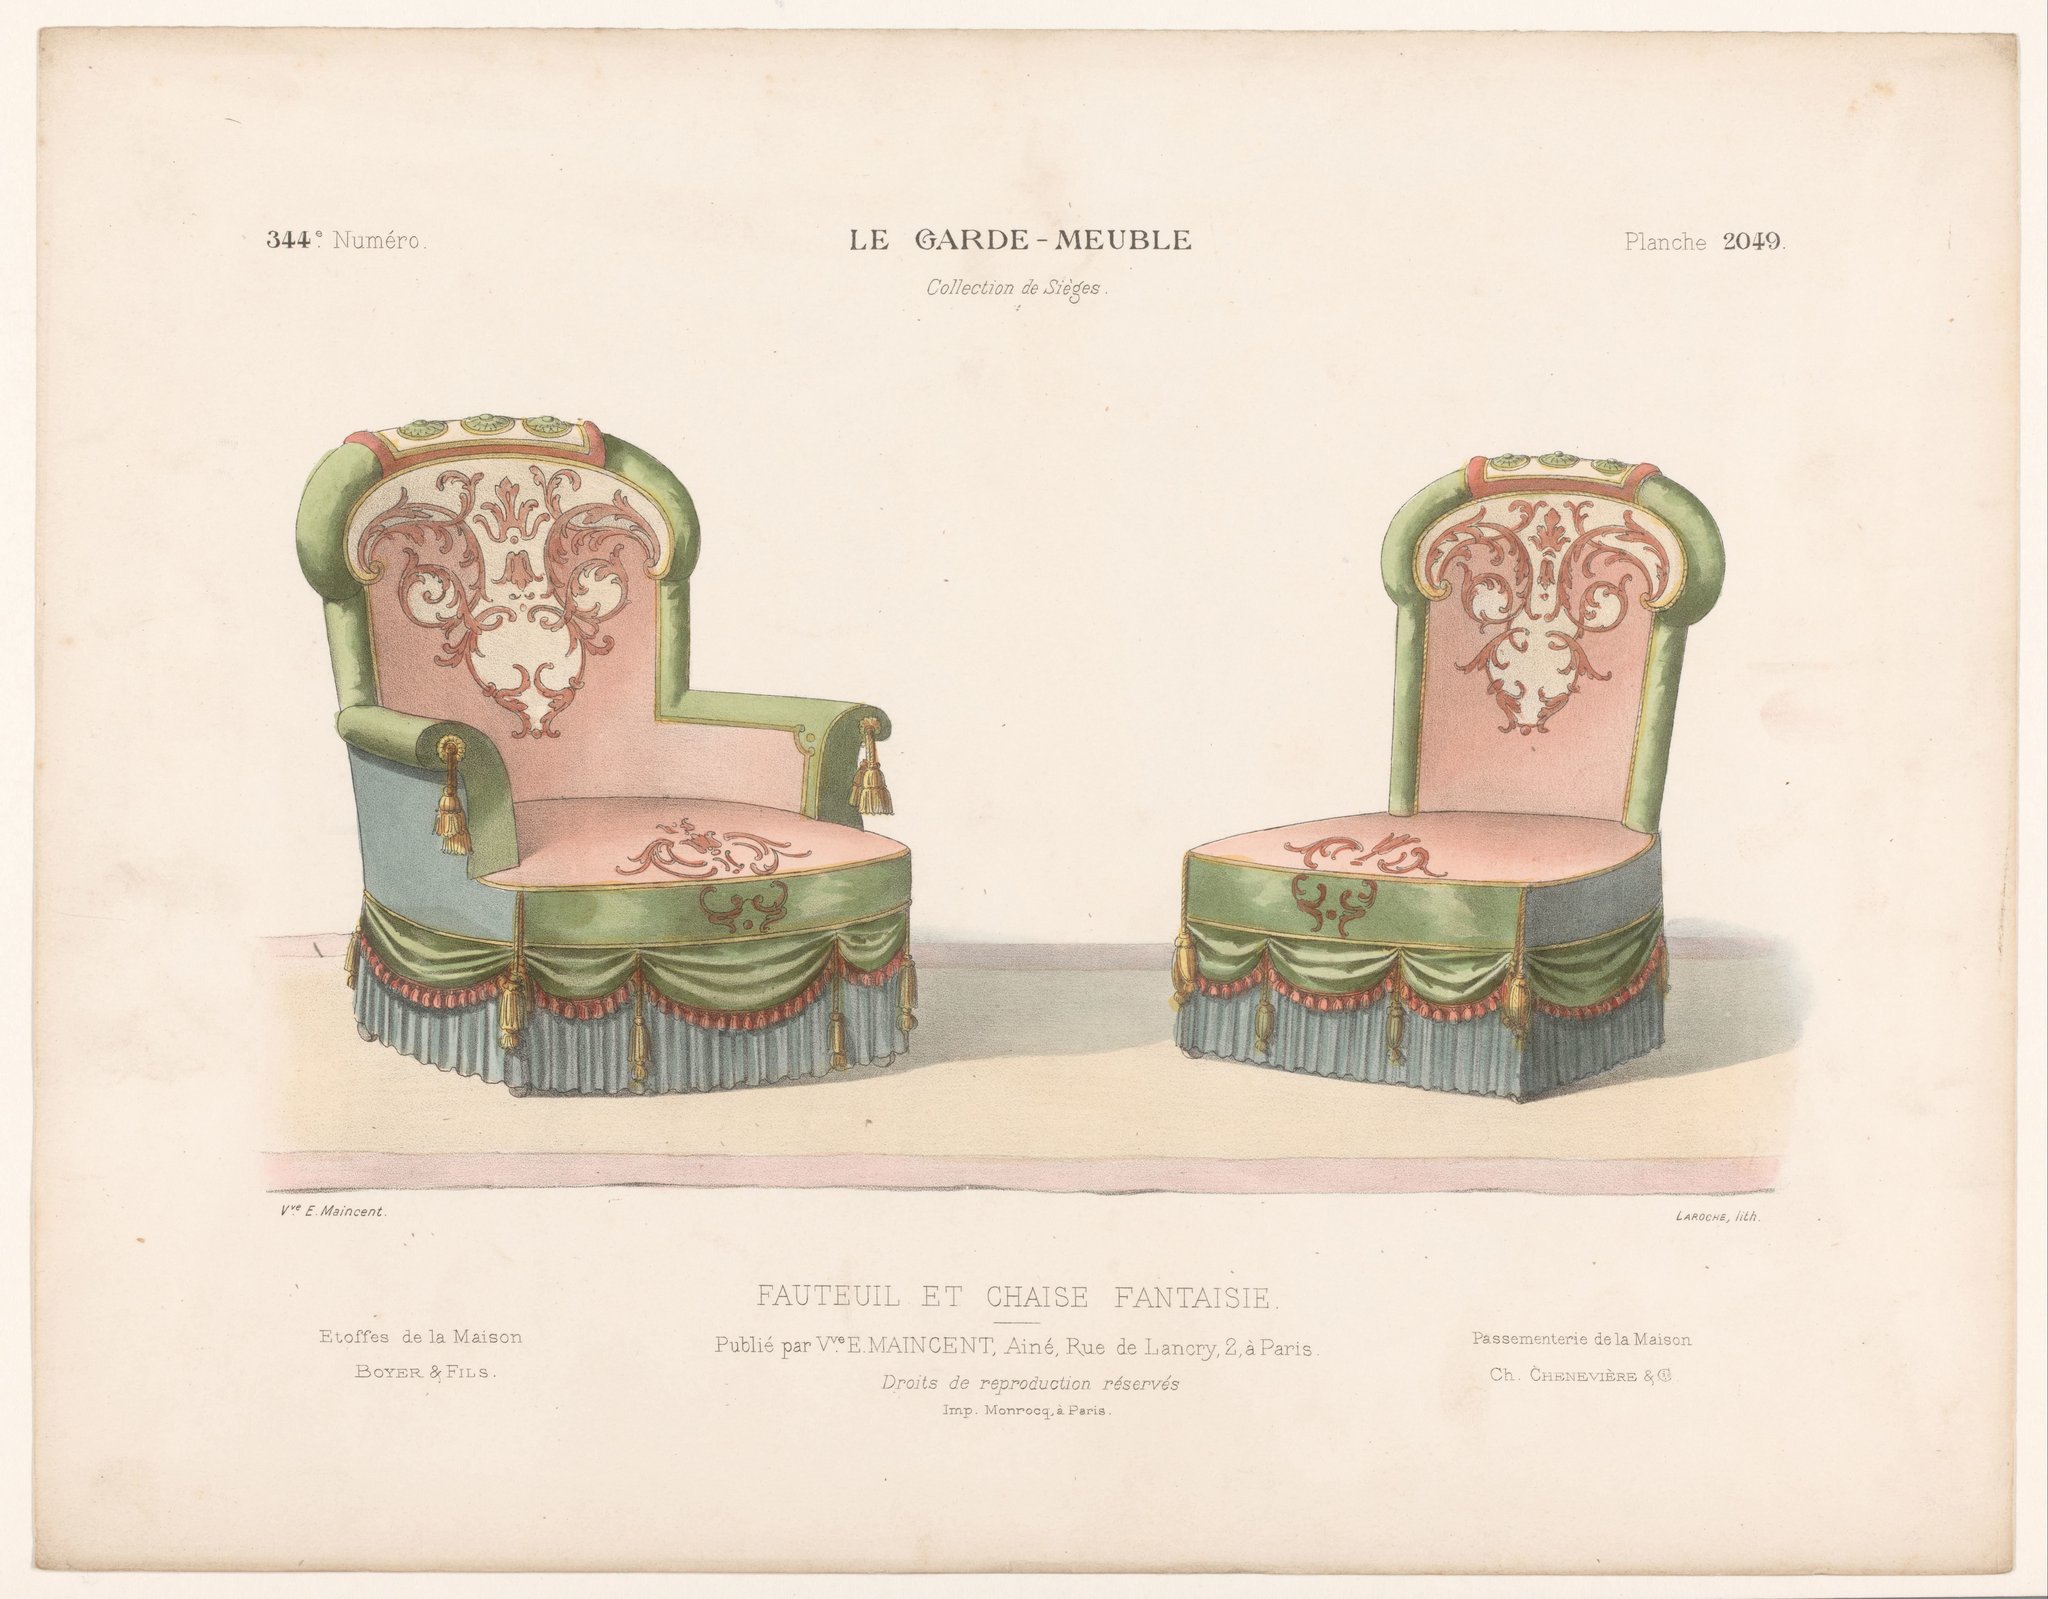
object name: print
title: Fauteuil et chaise fantaisie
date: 1895-1935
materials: paper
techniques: hand coloring, lithograph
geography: paris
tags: seating furniture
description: Ieder Livraison in de serie Le Garde-Meuble bevat negen platen: drie 'sièges' (zitmeubels), drie 'meubles' (diverse meubels zoals tafels en kasten) en drie 'tentures' (gordijnen en draperieën).